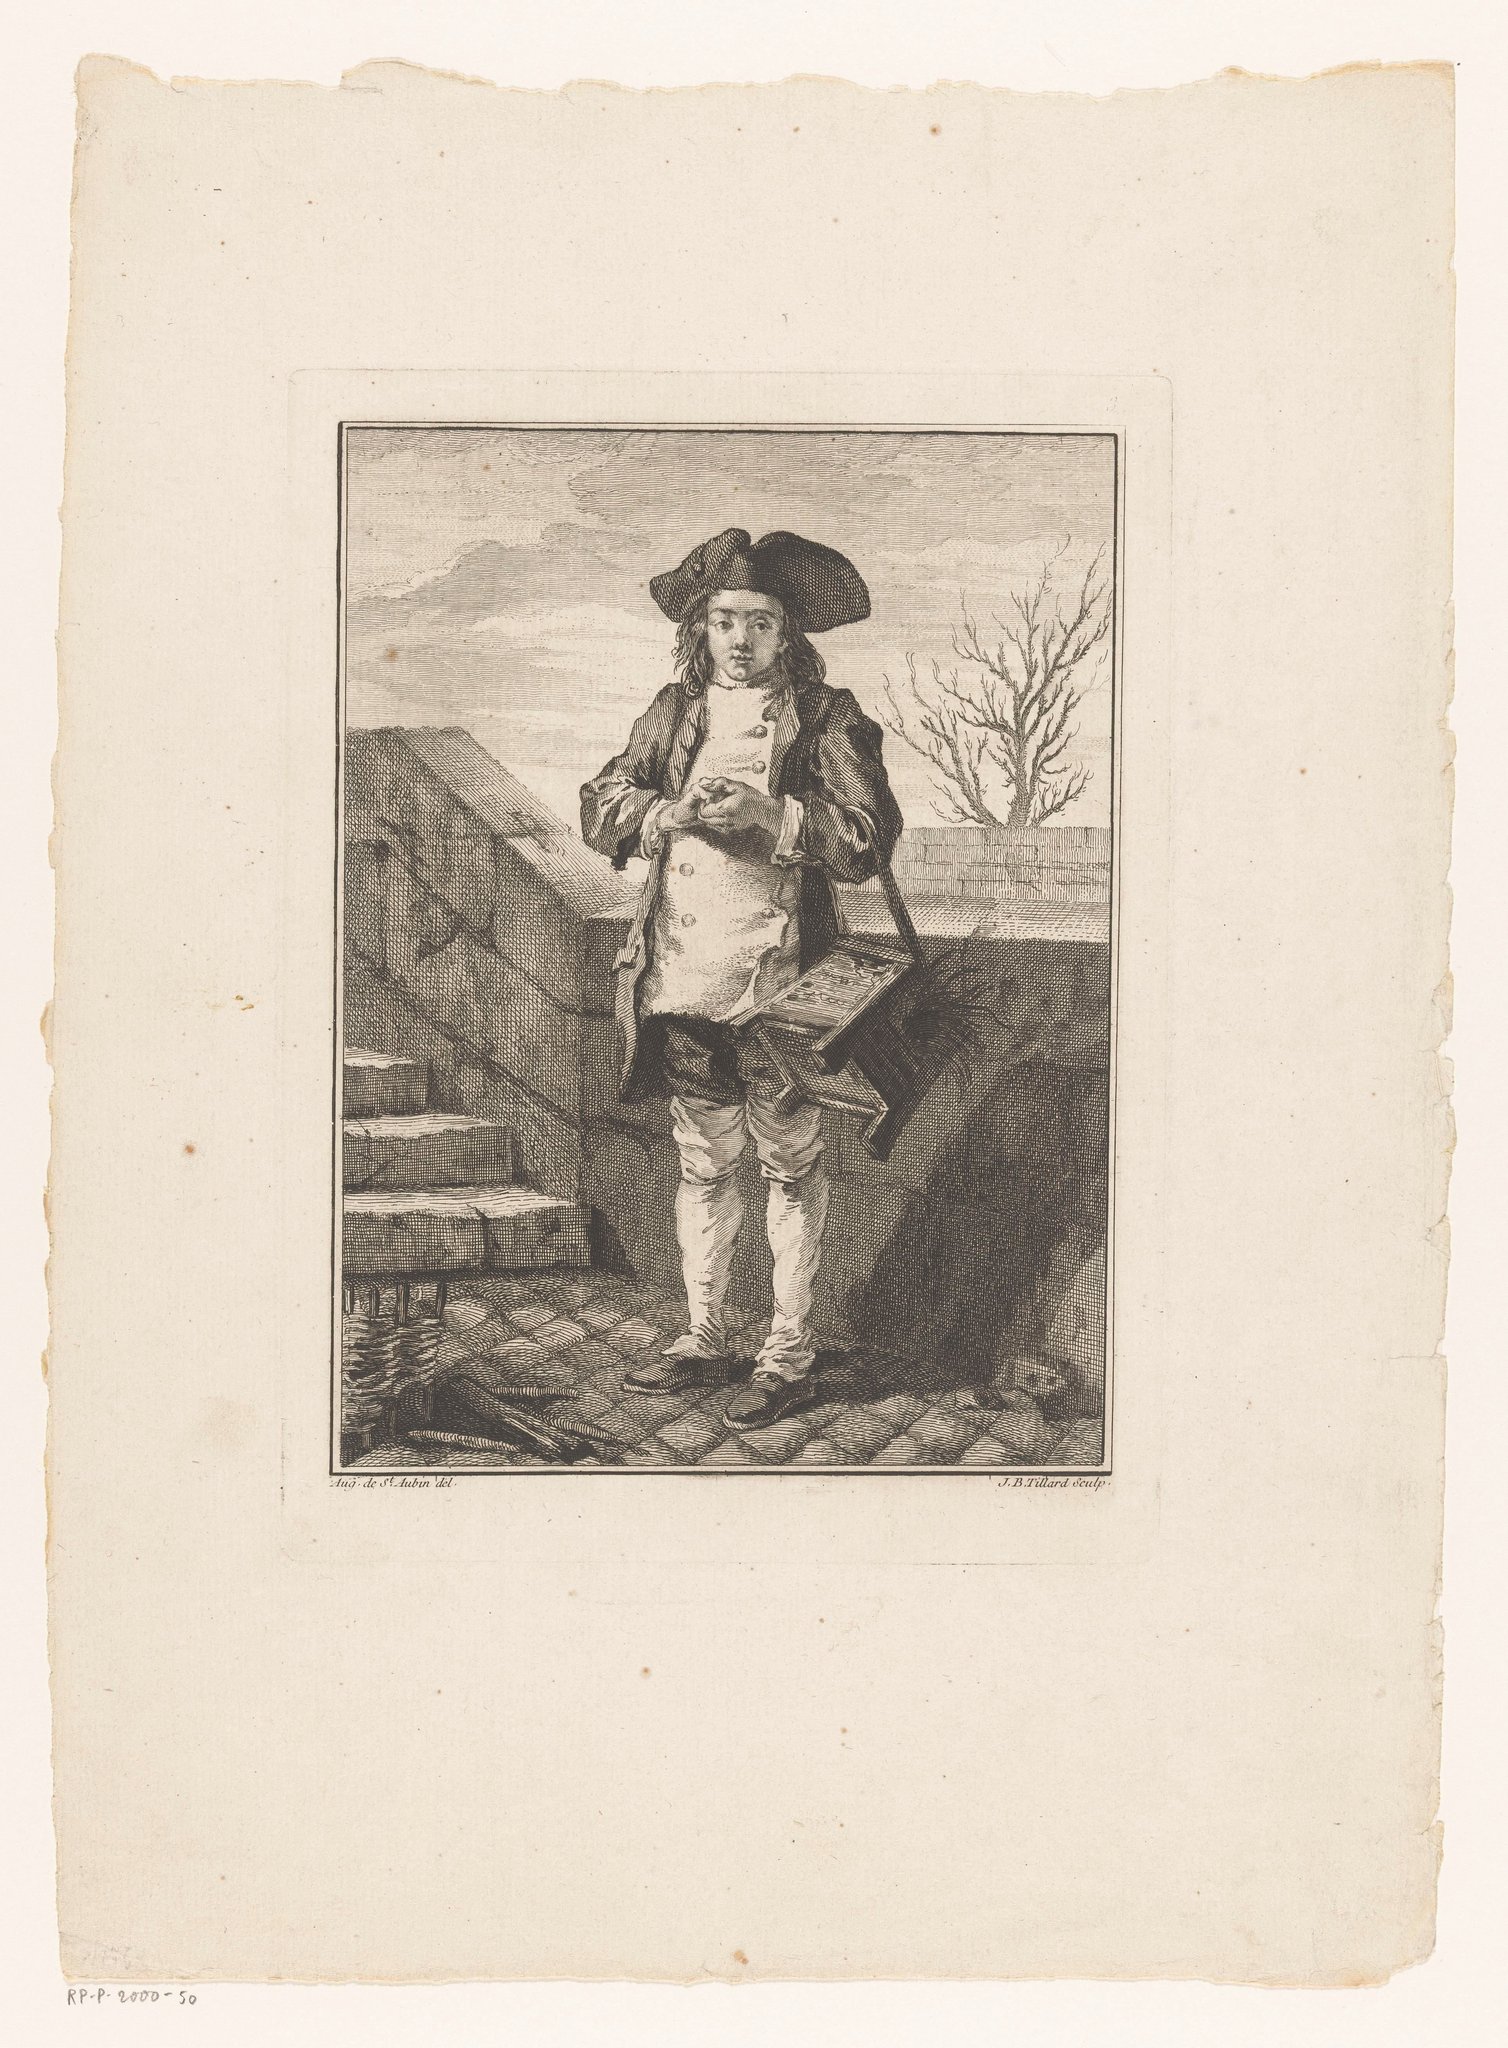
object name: print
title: Savoyard, staand voor een muur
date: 1766-1770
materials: paper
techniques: engraving, etching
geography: france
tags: flight of steps, 'fahrende leute', vagrants, street-trader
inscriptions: signature: ‘Aug. de St. Aubin del’, signature: ‘J.B. Tillard sculp.’, collector's mark: Lugt 2760, collector's mark: Lugt 2228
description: Maakt deel uit van een serie getiteld: "Mes Gens, ou les Commissionaires ultramontains, Les Savoyards", uitgegeven door Basan en de Saint-Aubin. De serie bestaat uit zes platen en een frontispice. Bij een latere editie is een achtste plaat toegevoegd.